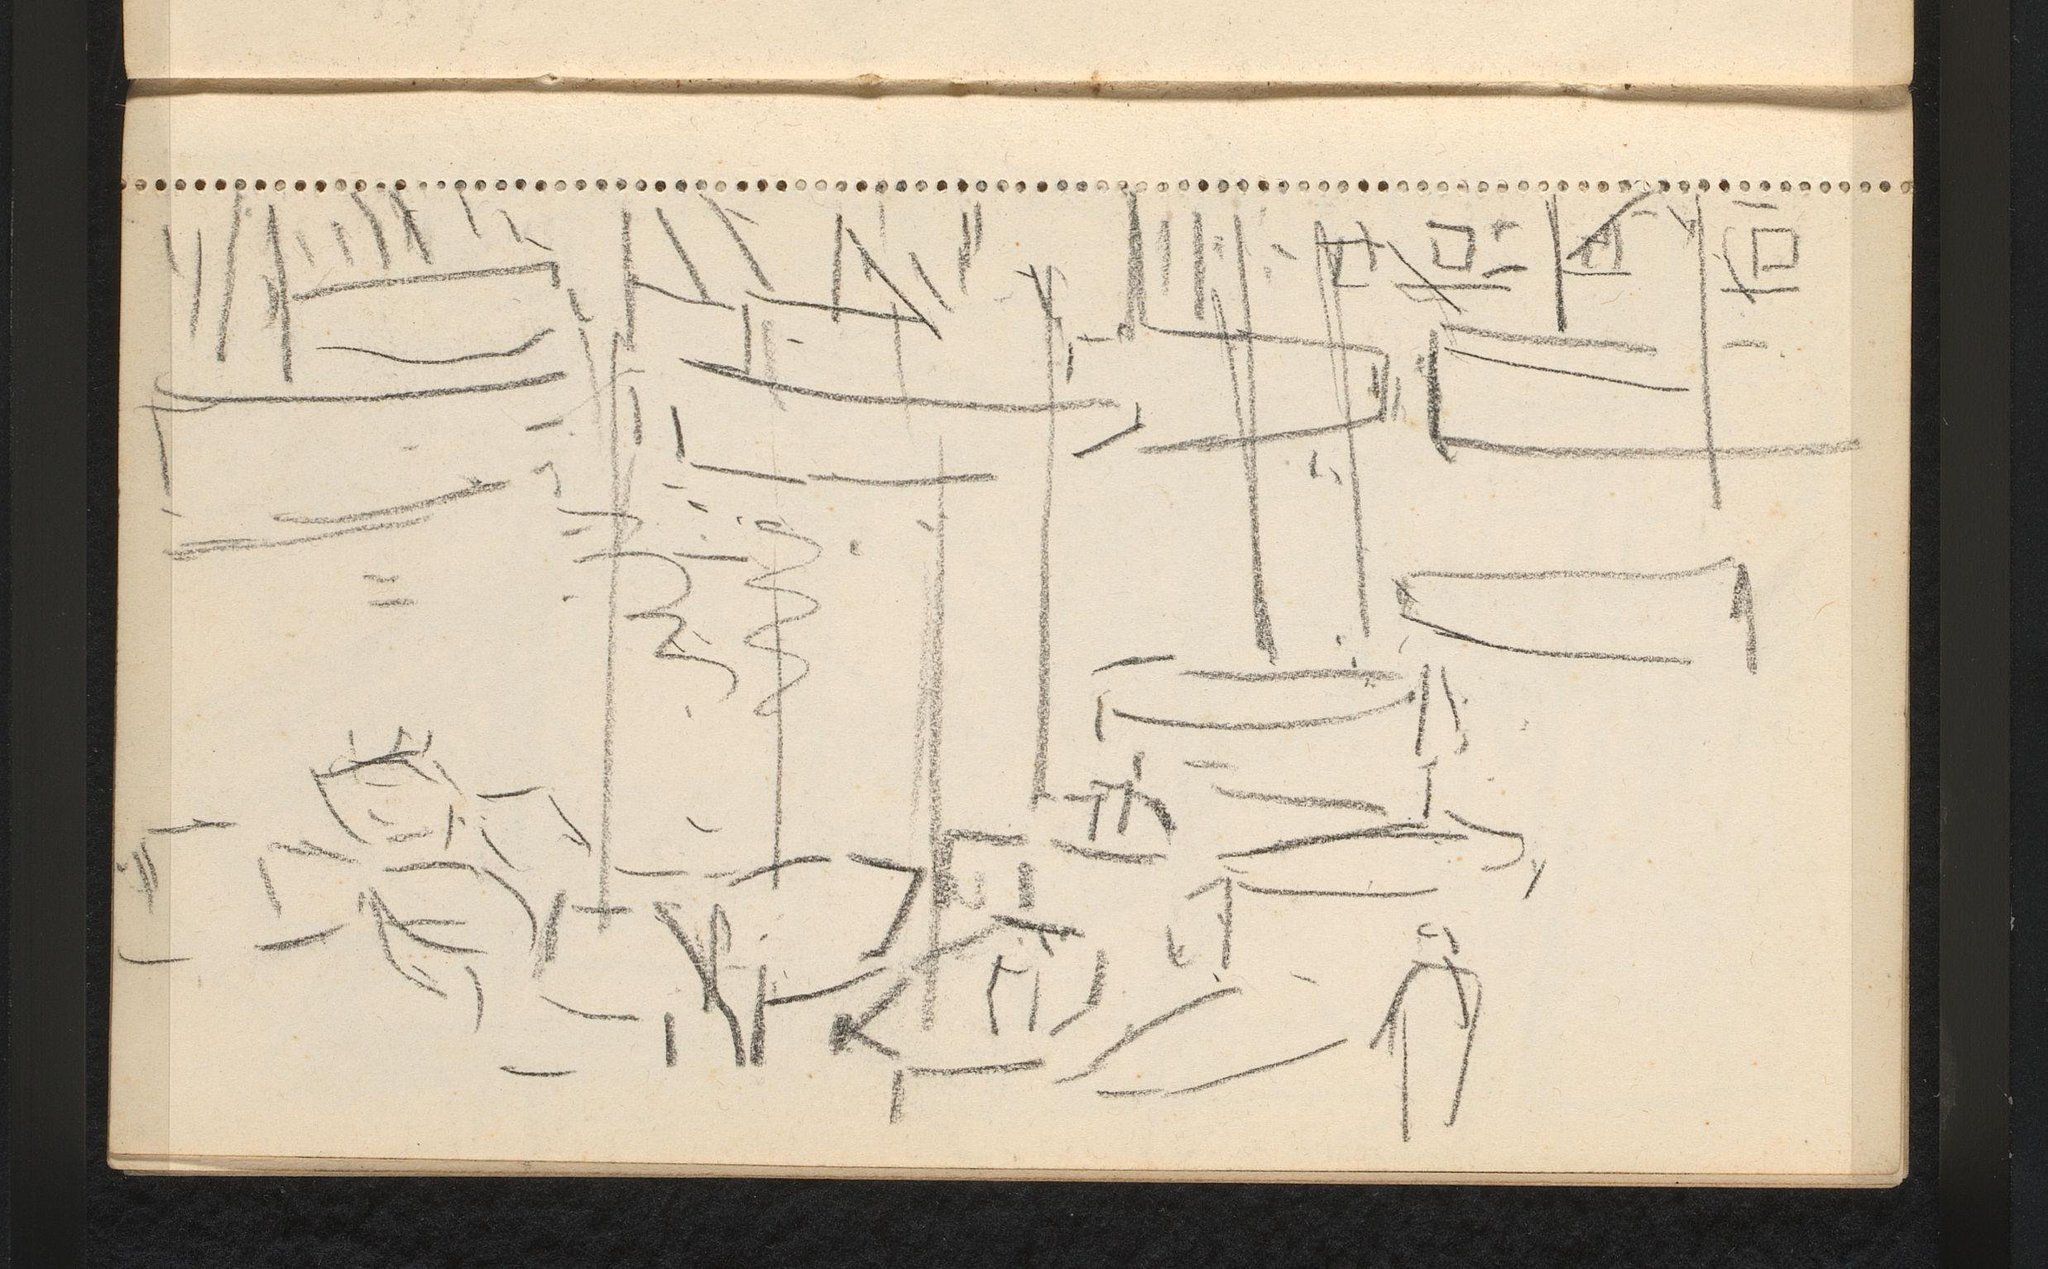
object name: sketchbook leaf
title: Vissersboten in een haven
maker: gerrit van blaaderen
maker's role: draughtsman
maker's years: 1873-1935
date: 1908-1927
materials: chalk, paper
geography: france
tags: harbour, sailing-ship, sailing-boat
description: Blad 27 recto uit een schetsboek met 33 bladen.